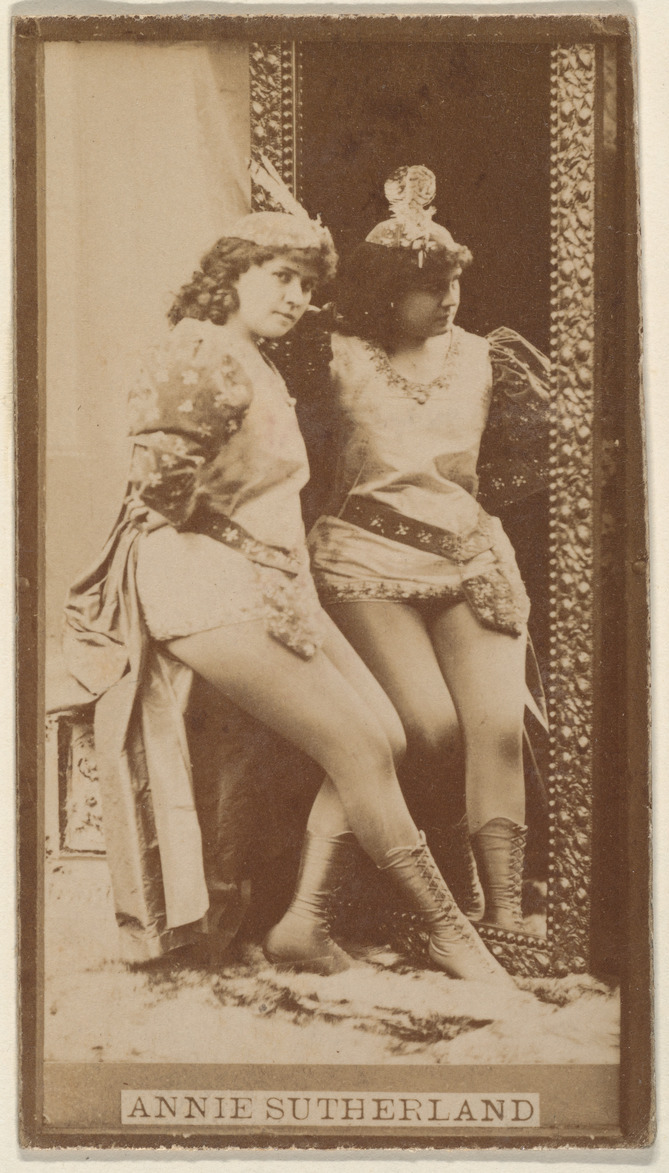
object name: photograph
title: Annie Sutherland, from the Actresses series (N668)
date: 1888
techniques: albumen silver print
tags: portraits,women,actresses,mirrors